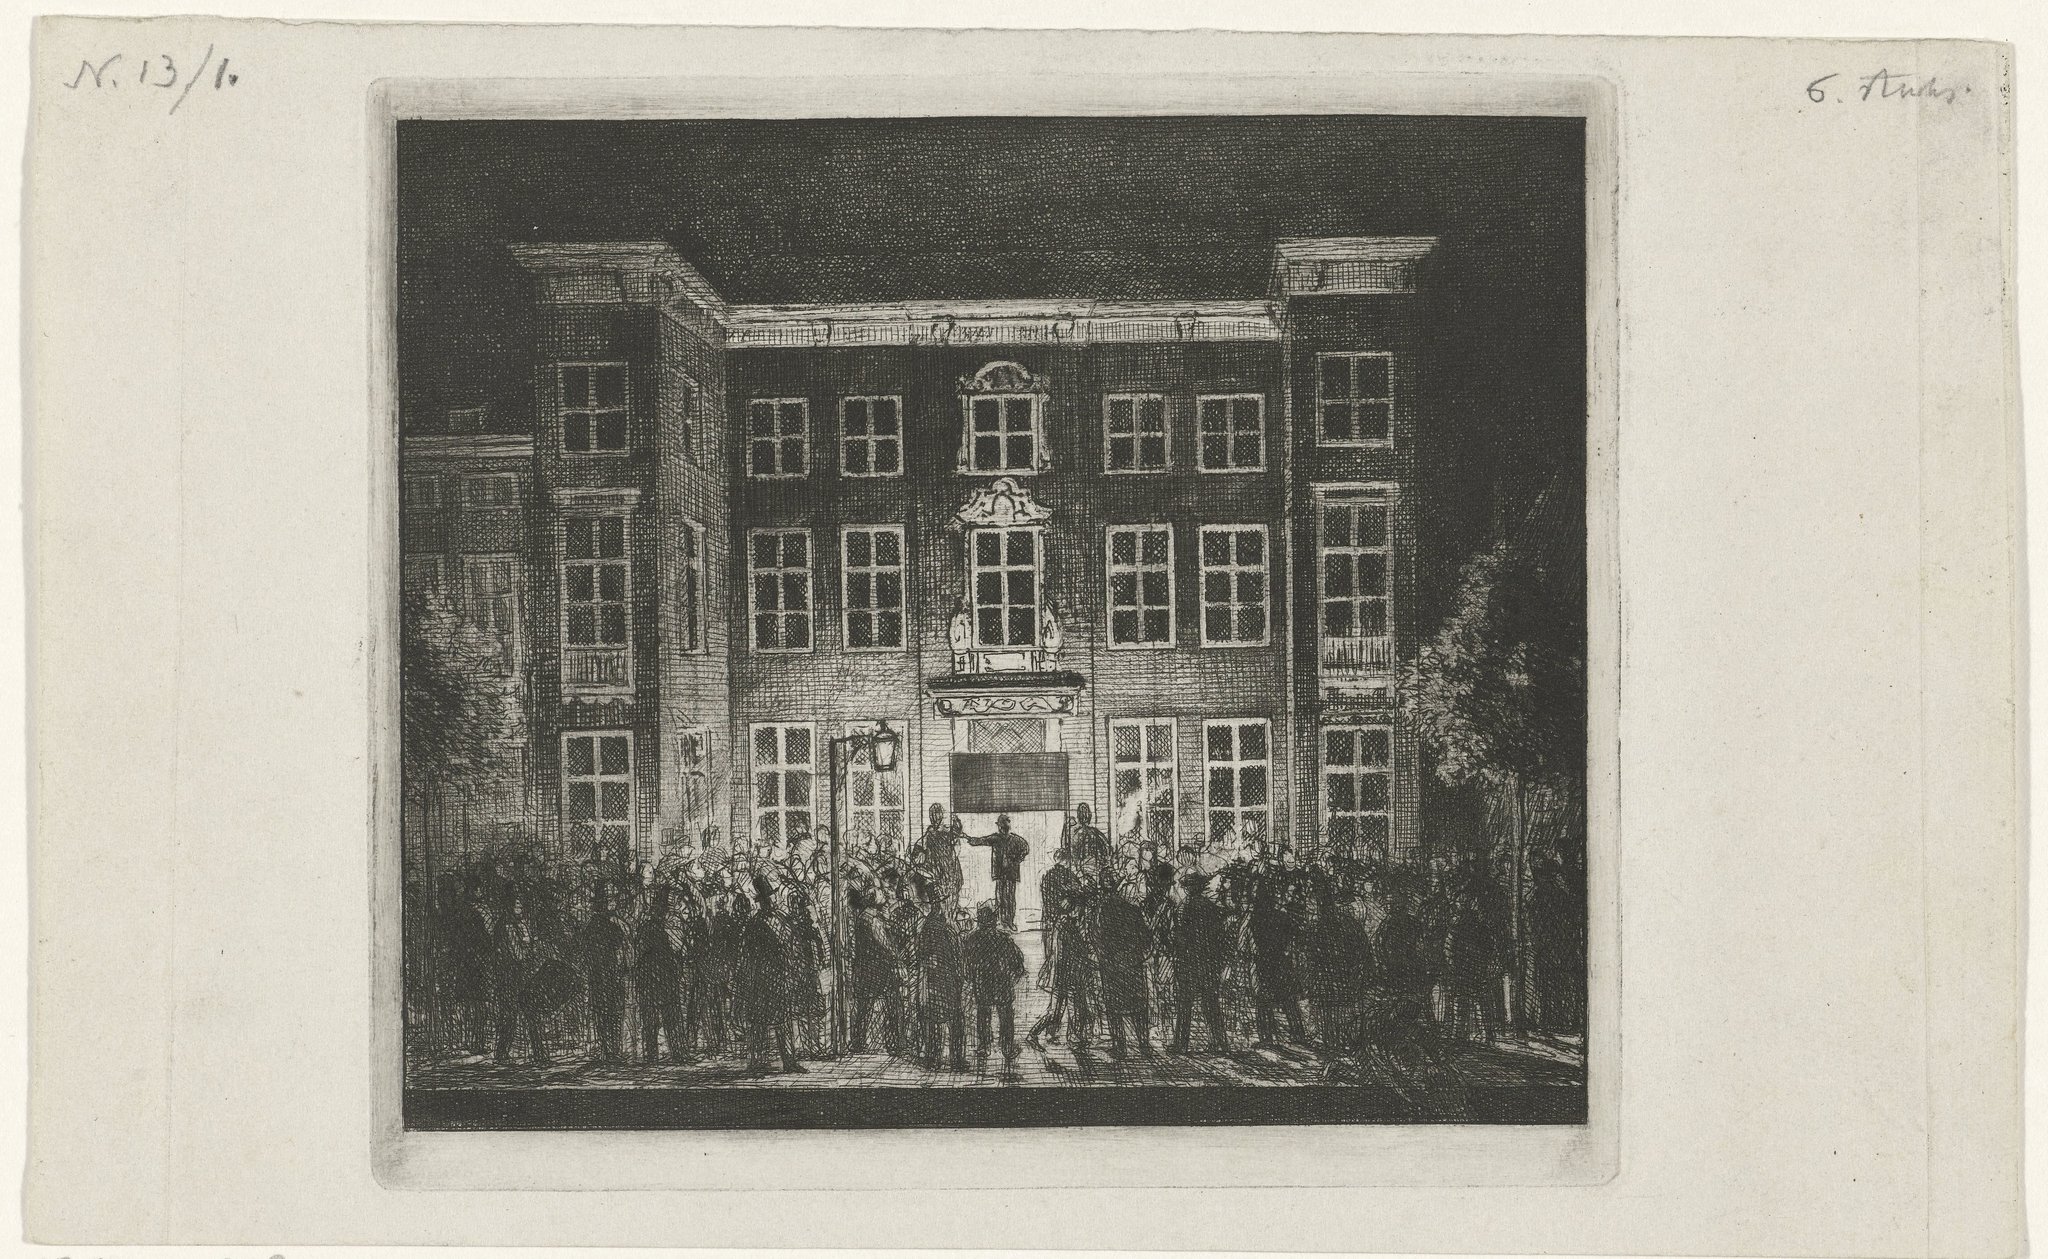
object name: print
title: Begrafenis van de Delftsche academie, 30 juni 1864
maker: cornelis van der griendt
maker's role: draughtsman, painter, print maker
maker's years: 1827-1918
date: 1864-1866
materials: paper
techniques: drypoint, etching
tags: public festivities, delft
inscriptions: collector's mark: Lugt 2228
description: De begrafenis van de Delftsche academie, 30 juni 1864. Nachtelijk tafereel waarbij in de verlichte deuropening van een pand een persoon staat te oreren voor publiek.